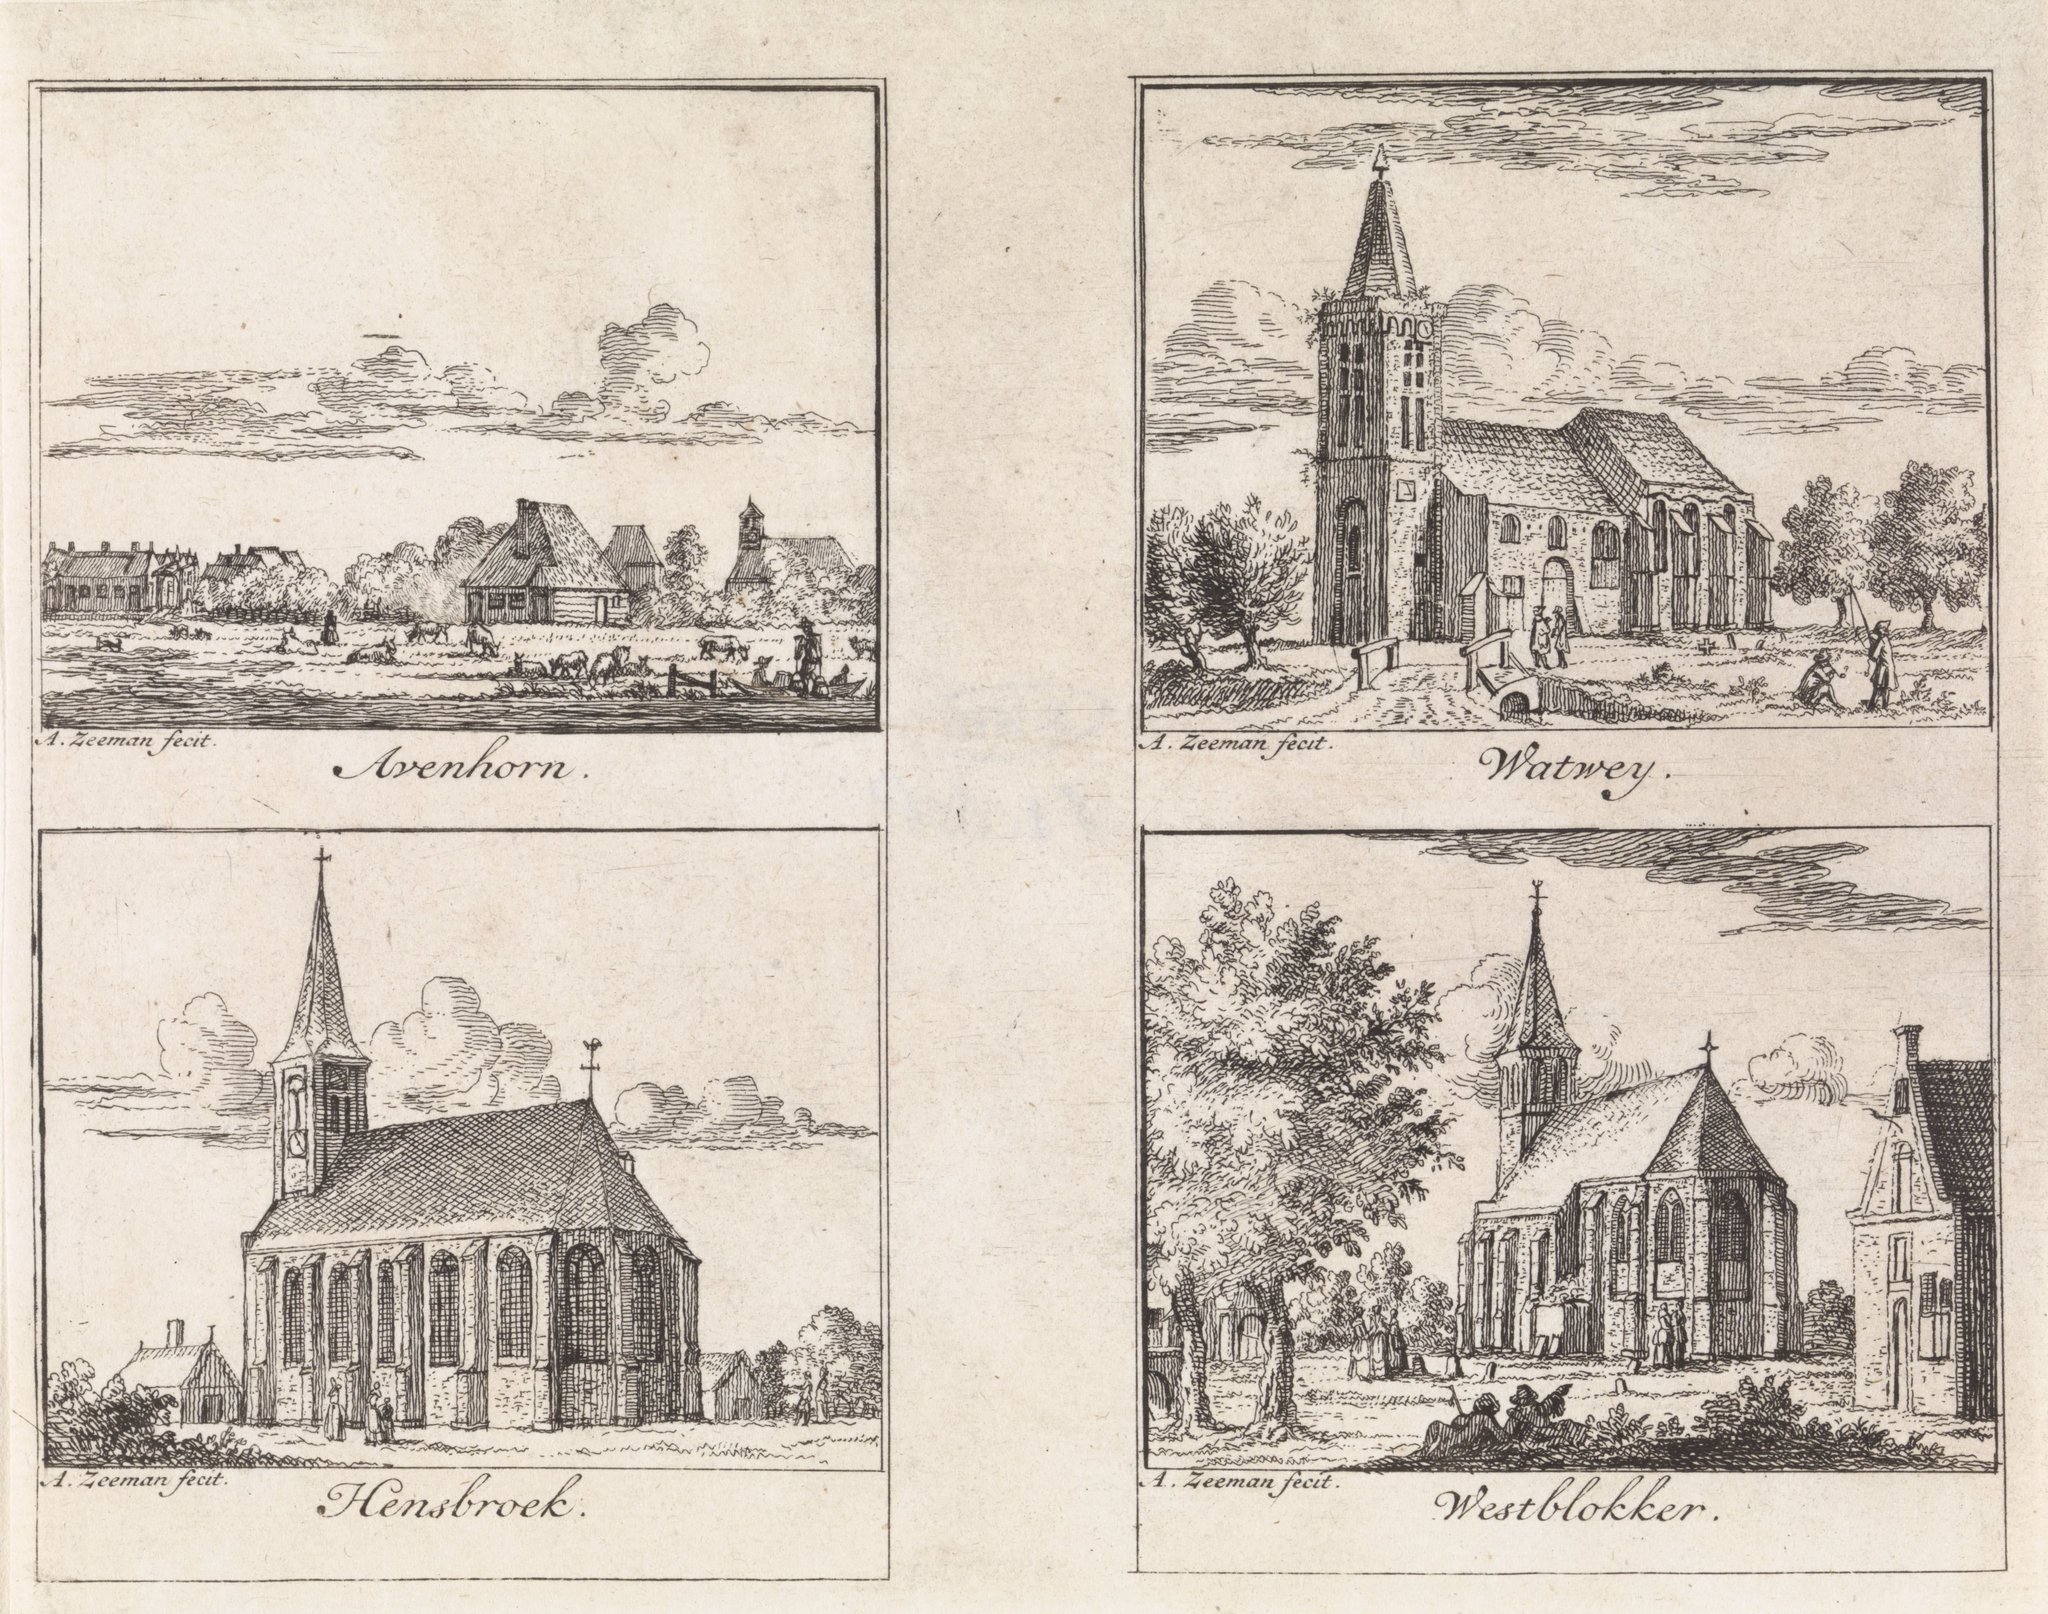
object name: print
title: Avenhorn/ Hensbroek / Watwey / Westblokker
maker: abraham zeeman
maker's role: print maker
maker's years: 1695-1754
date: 1732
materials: paper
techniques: etching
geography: amsterdam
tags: prospect of village, silhouette of village, church (exterior)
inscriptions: collector's mark: Lugt 2228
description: Vier voorstellingen op een blad. Linksboven: Gezicht op het dorp Avenhorn. Linksonder: Gezicht op de kerk van Hensbroek. Rechtsboven: Gezicht op de kerk van Wadway. Rechtsonder: Gezicht op de kerk van Westerblokker.